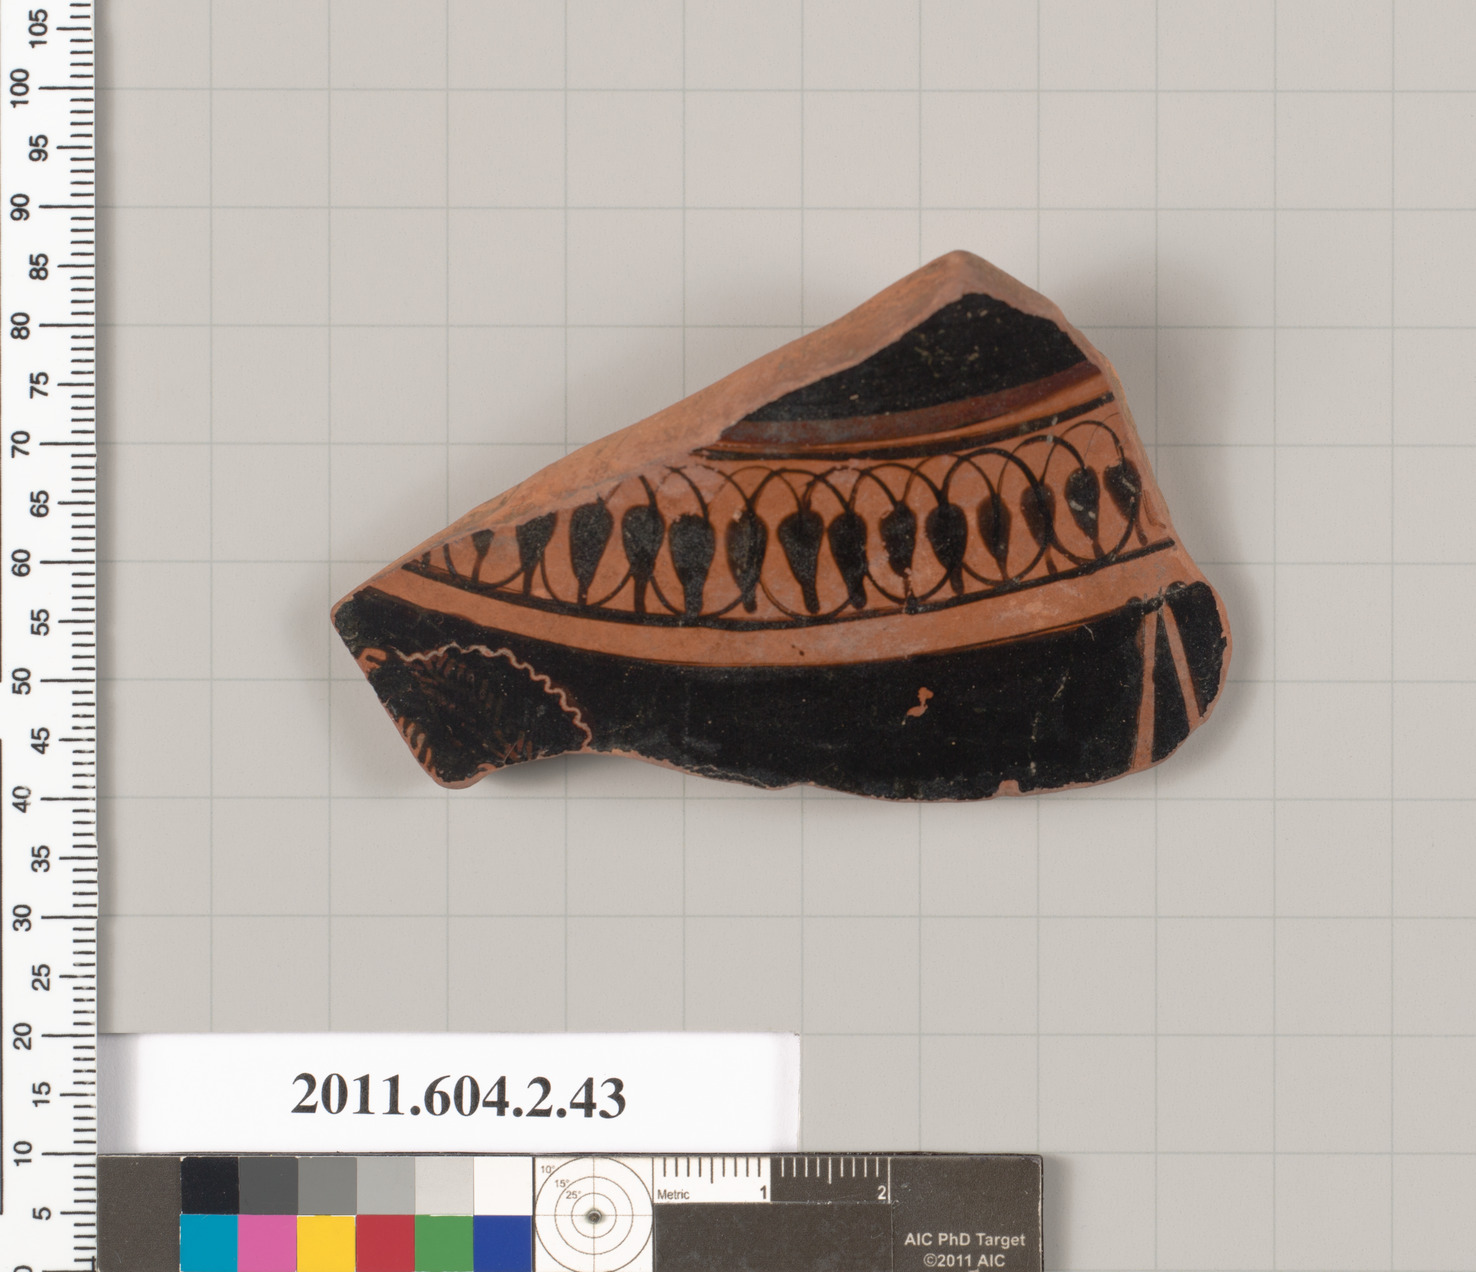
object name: pelike fragment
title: Terracotta fragment of a pelike (jar)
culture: greek, attic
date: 534-468 BCE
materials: terracotta